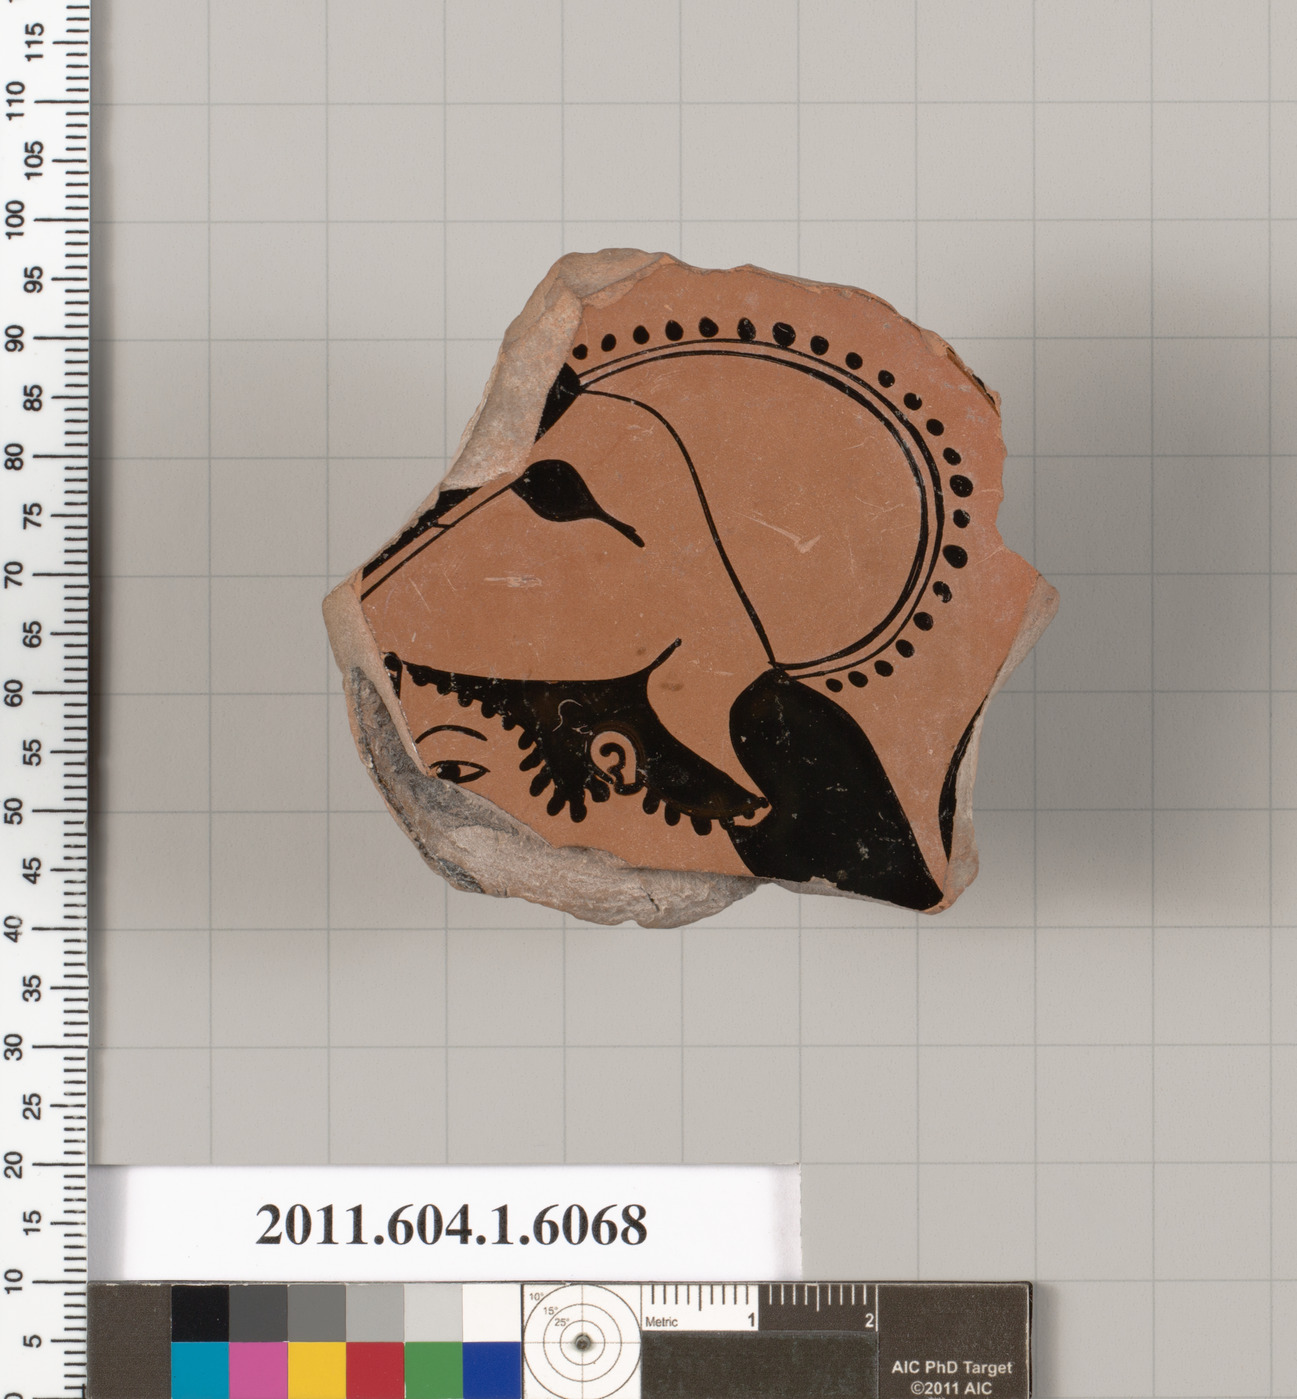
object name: kylix fragment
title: Terracotta fragment of a kylix (drinking cup)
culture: greek, attic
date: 510-500 BCE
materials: terracotta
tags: helmets